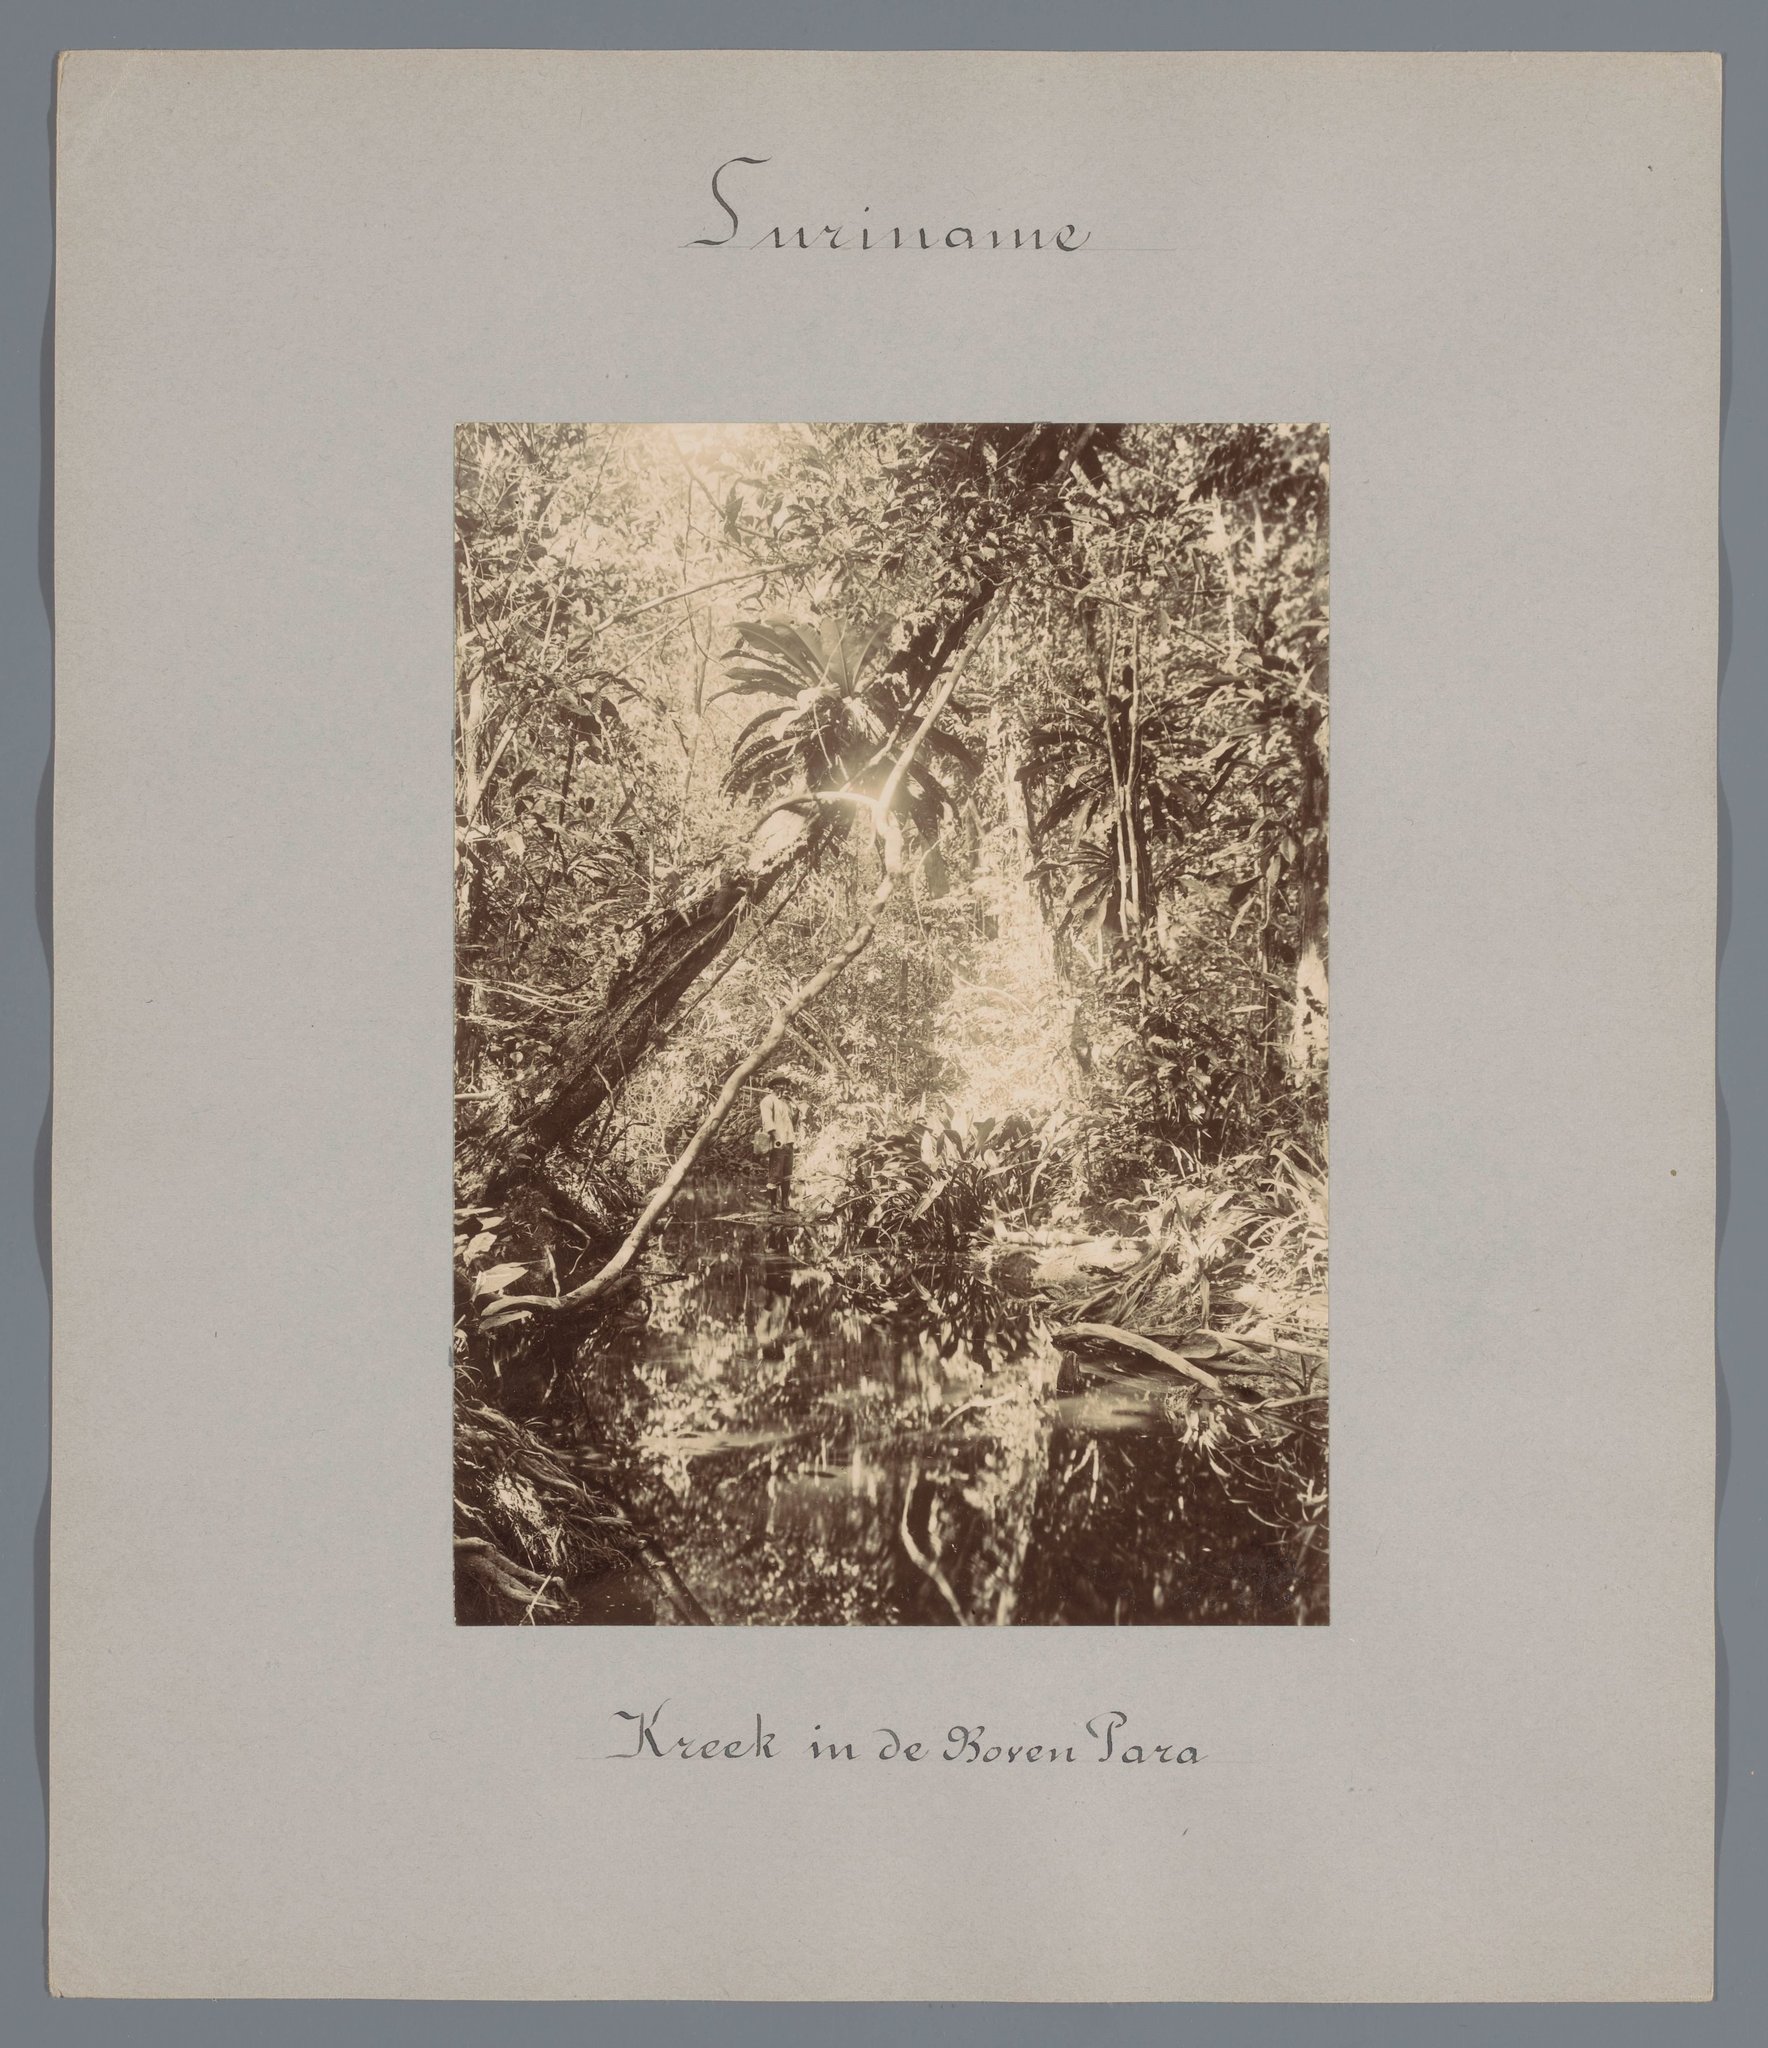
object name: photograph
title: Kreek in de Boven Para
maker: eugen klein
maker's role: fotograaf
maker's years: 1869-1927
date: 1900-1905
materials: cardboard, photographic support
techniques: gelatin silver print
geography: suriname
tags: suriname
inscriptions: inscription: ‘Suriname / Kreek in de Boven Para’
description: Een kreek in het oerwoud in de Boven Para. Op een boomstam staat een man met een geweer over de schouder. Onderdeel van een groep van 44 foto's van Paramaribo, Suriname en Curaçao, ca. 1900-1905, opgeplakt op kartons en voorzien van opschriften.